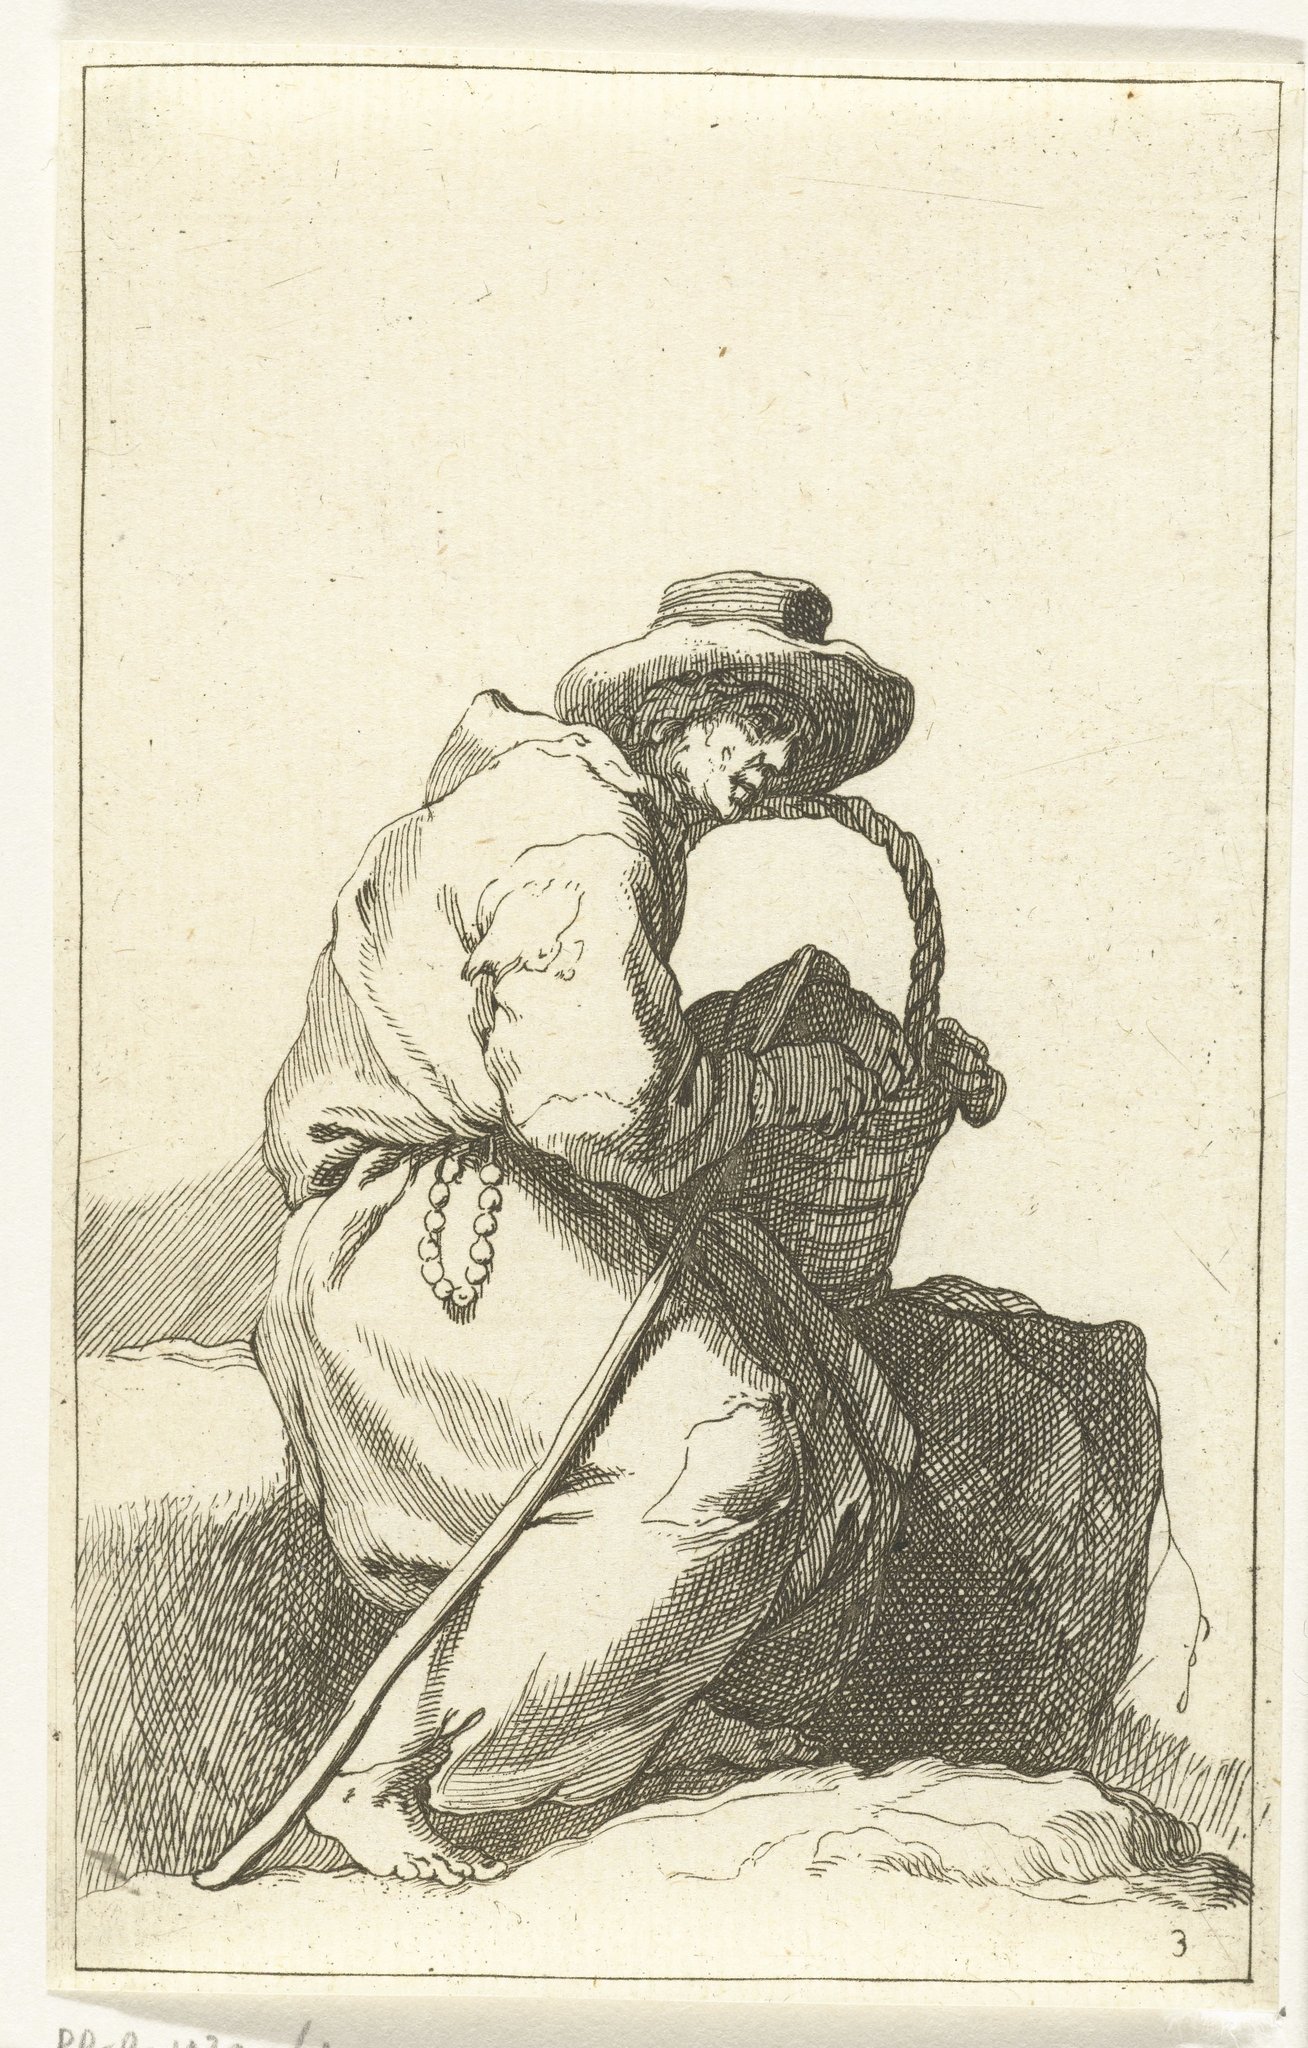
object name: print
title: Zittende boer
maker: frederick bloemaert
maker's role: print maker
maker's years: 1614-1669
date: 1635-1669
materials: paper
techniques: engraving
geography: utrecht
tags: farmers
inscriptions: collector's mark: Lugt 2233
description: Een zittende boer met gezicht naar voren gewend, op zijn schoot rust een mand en een stok.